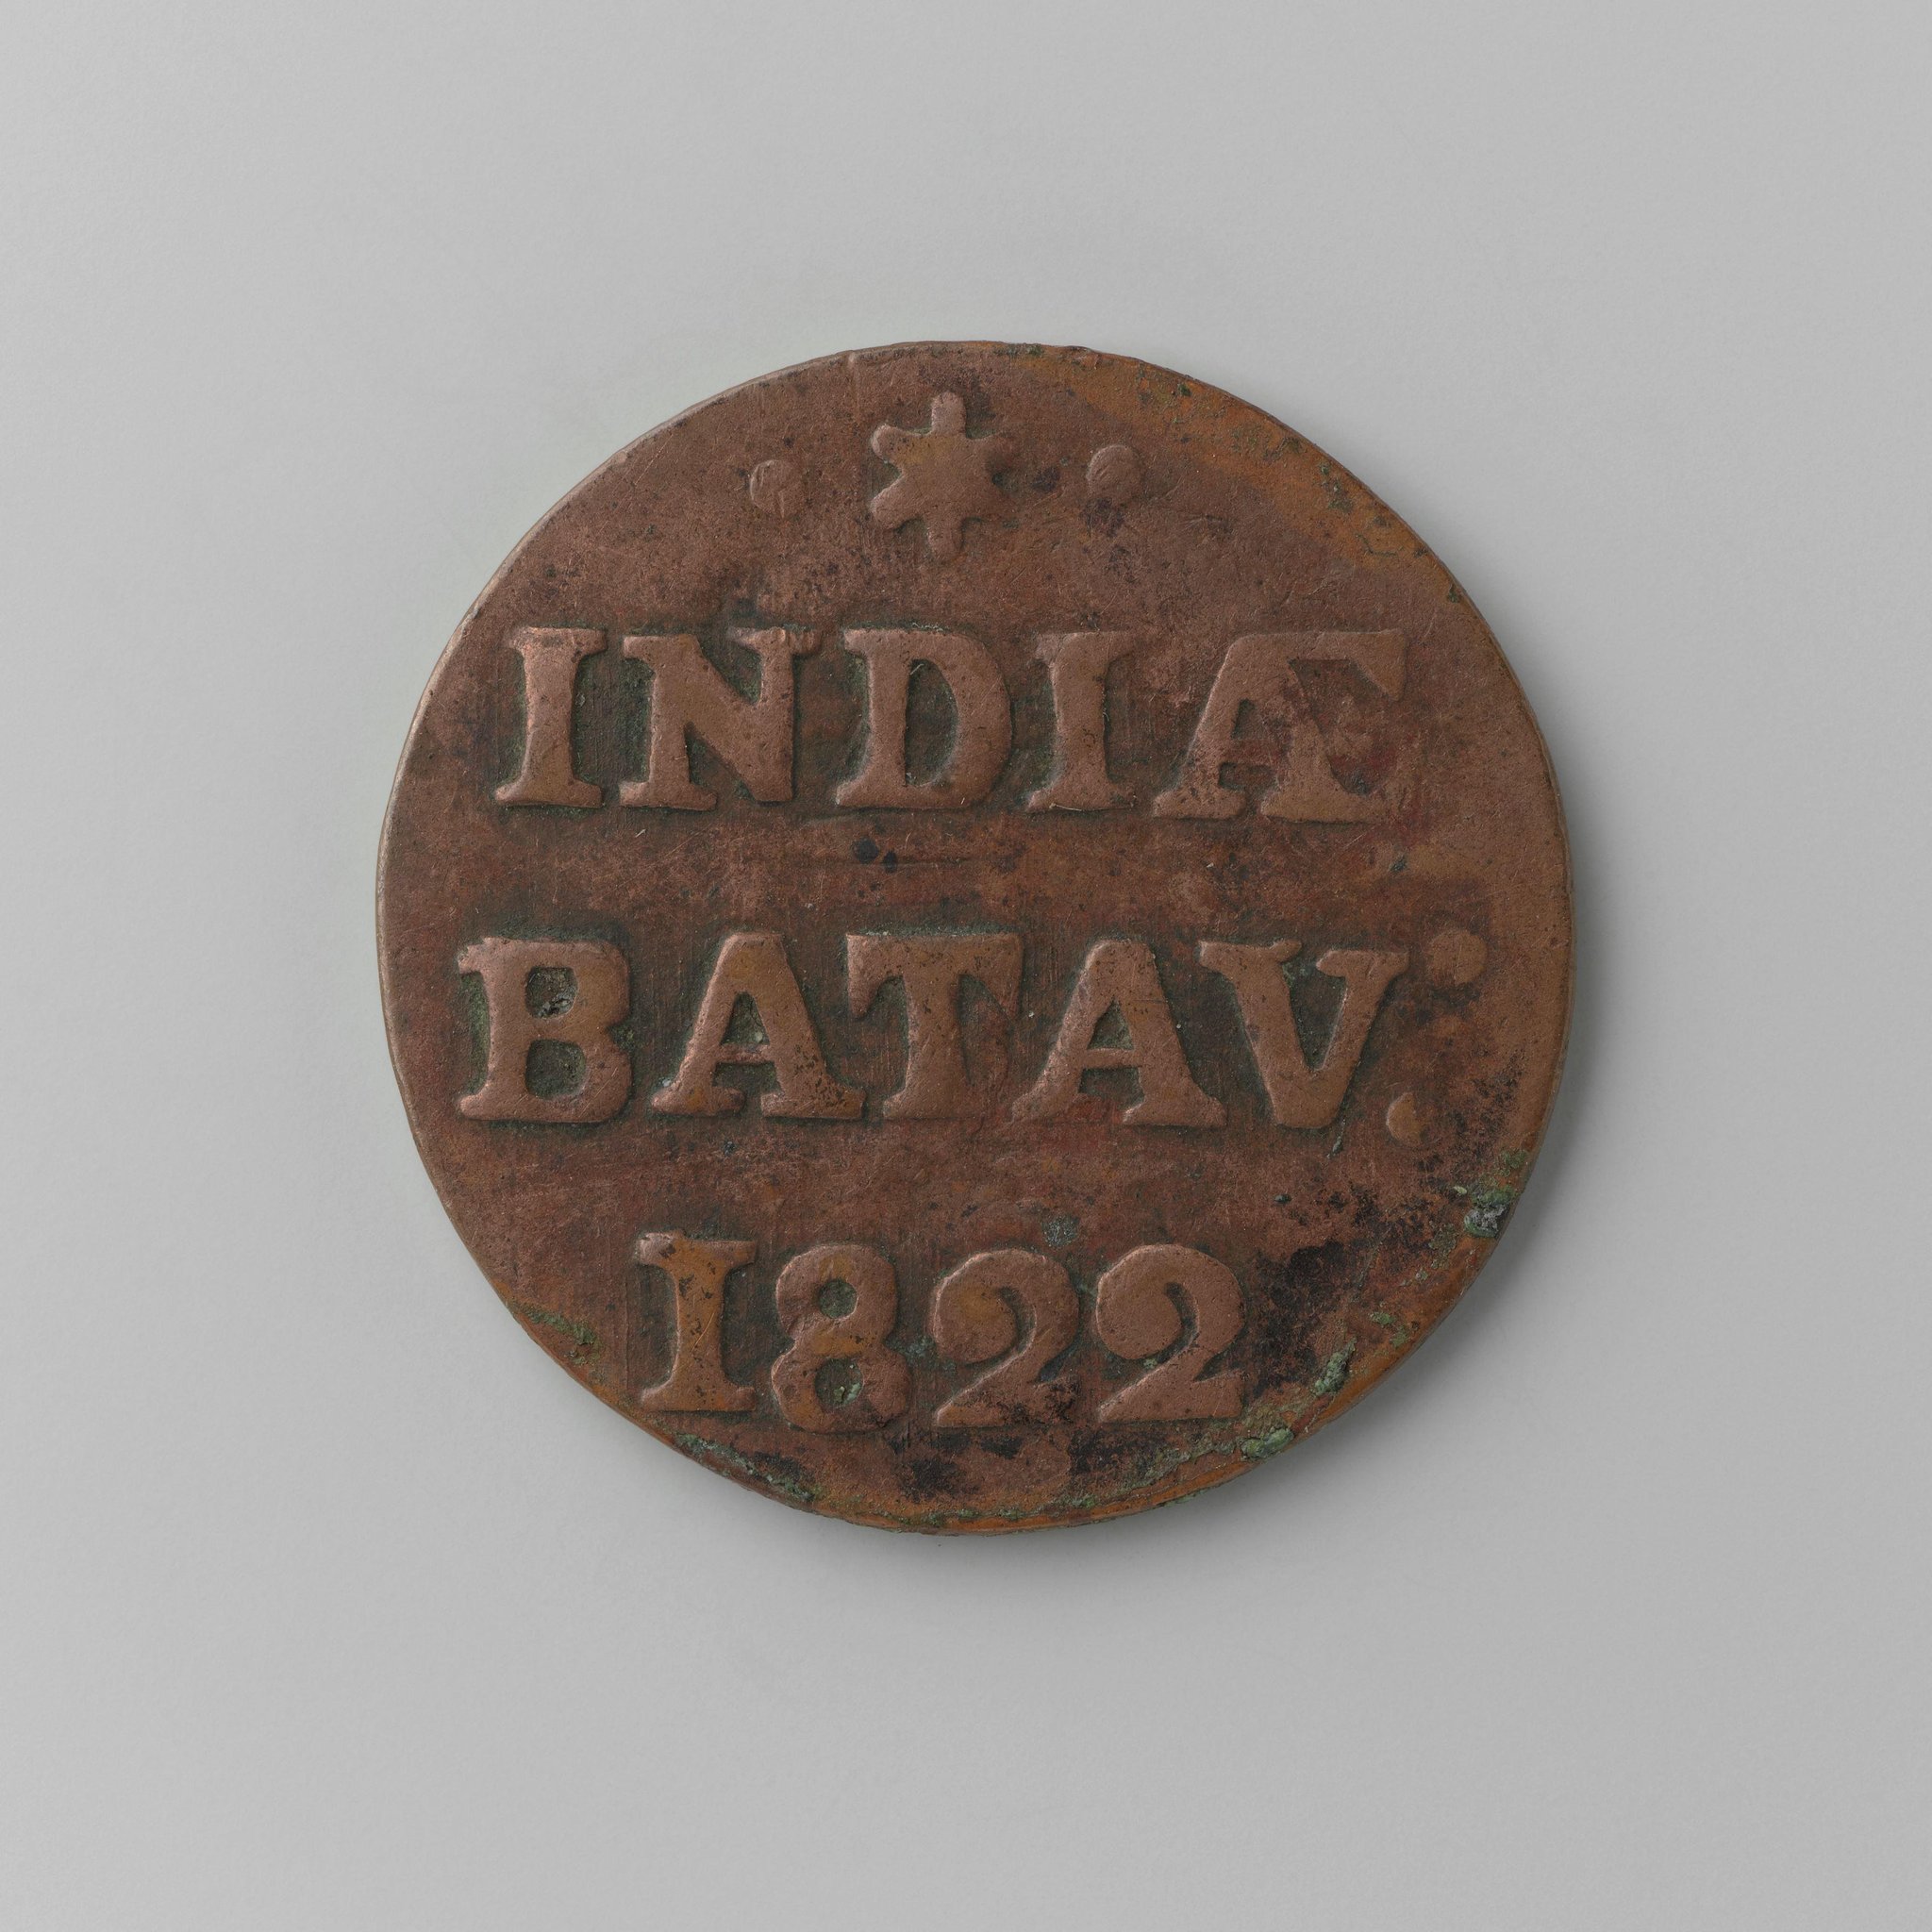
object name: coin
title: Nederlands Indië, duit,1822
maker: william i of the netherlands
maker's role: koning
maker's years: 1772-1843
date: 1822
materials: copper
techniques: striking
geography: surabaya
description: Koperen munt. Voorzijde: tussen waarde-aanduiding 5 1/16 G. gekroond generaliteitswapenschild. Keerzijde: tweeregelig opschrift, waarboven muntteken en waaronder jaartal. Gladde rand.